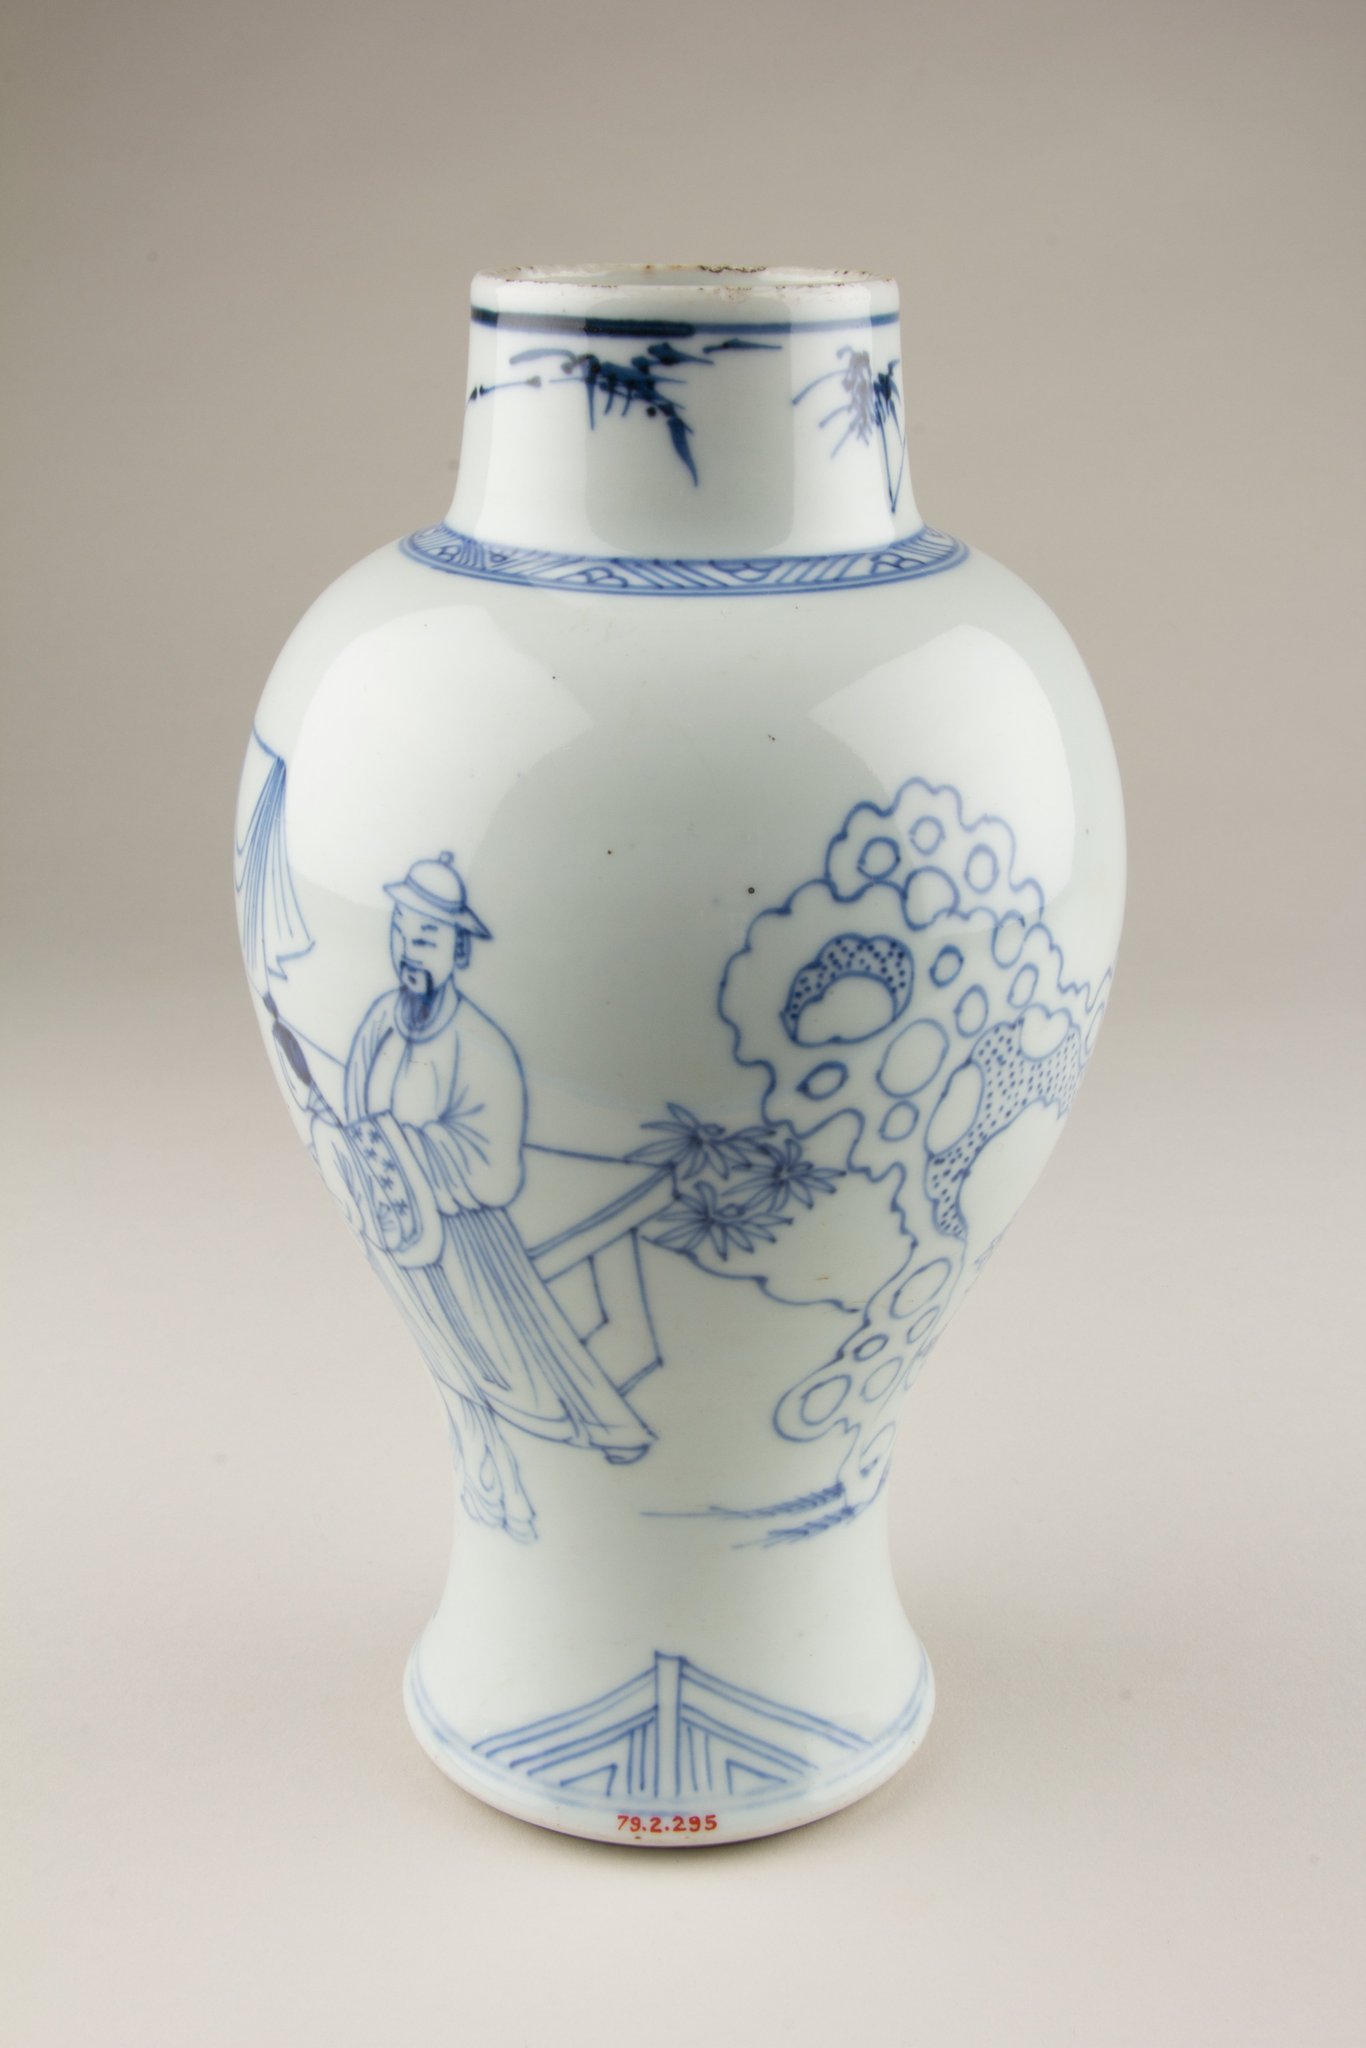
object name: vase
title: Vase with scholars in a garden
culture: chinese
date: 1667-1733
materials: cobalt, porcelain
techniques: painting, underglaze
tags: men,women